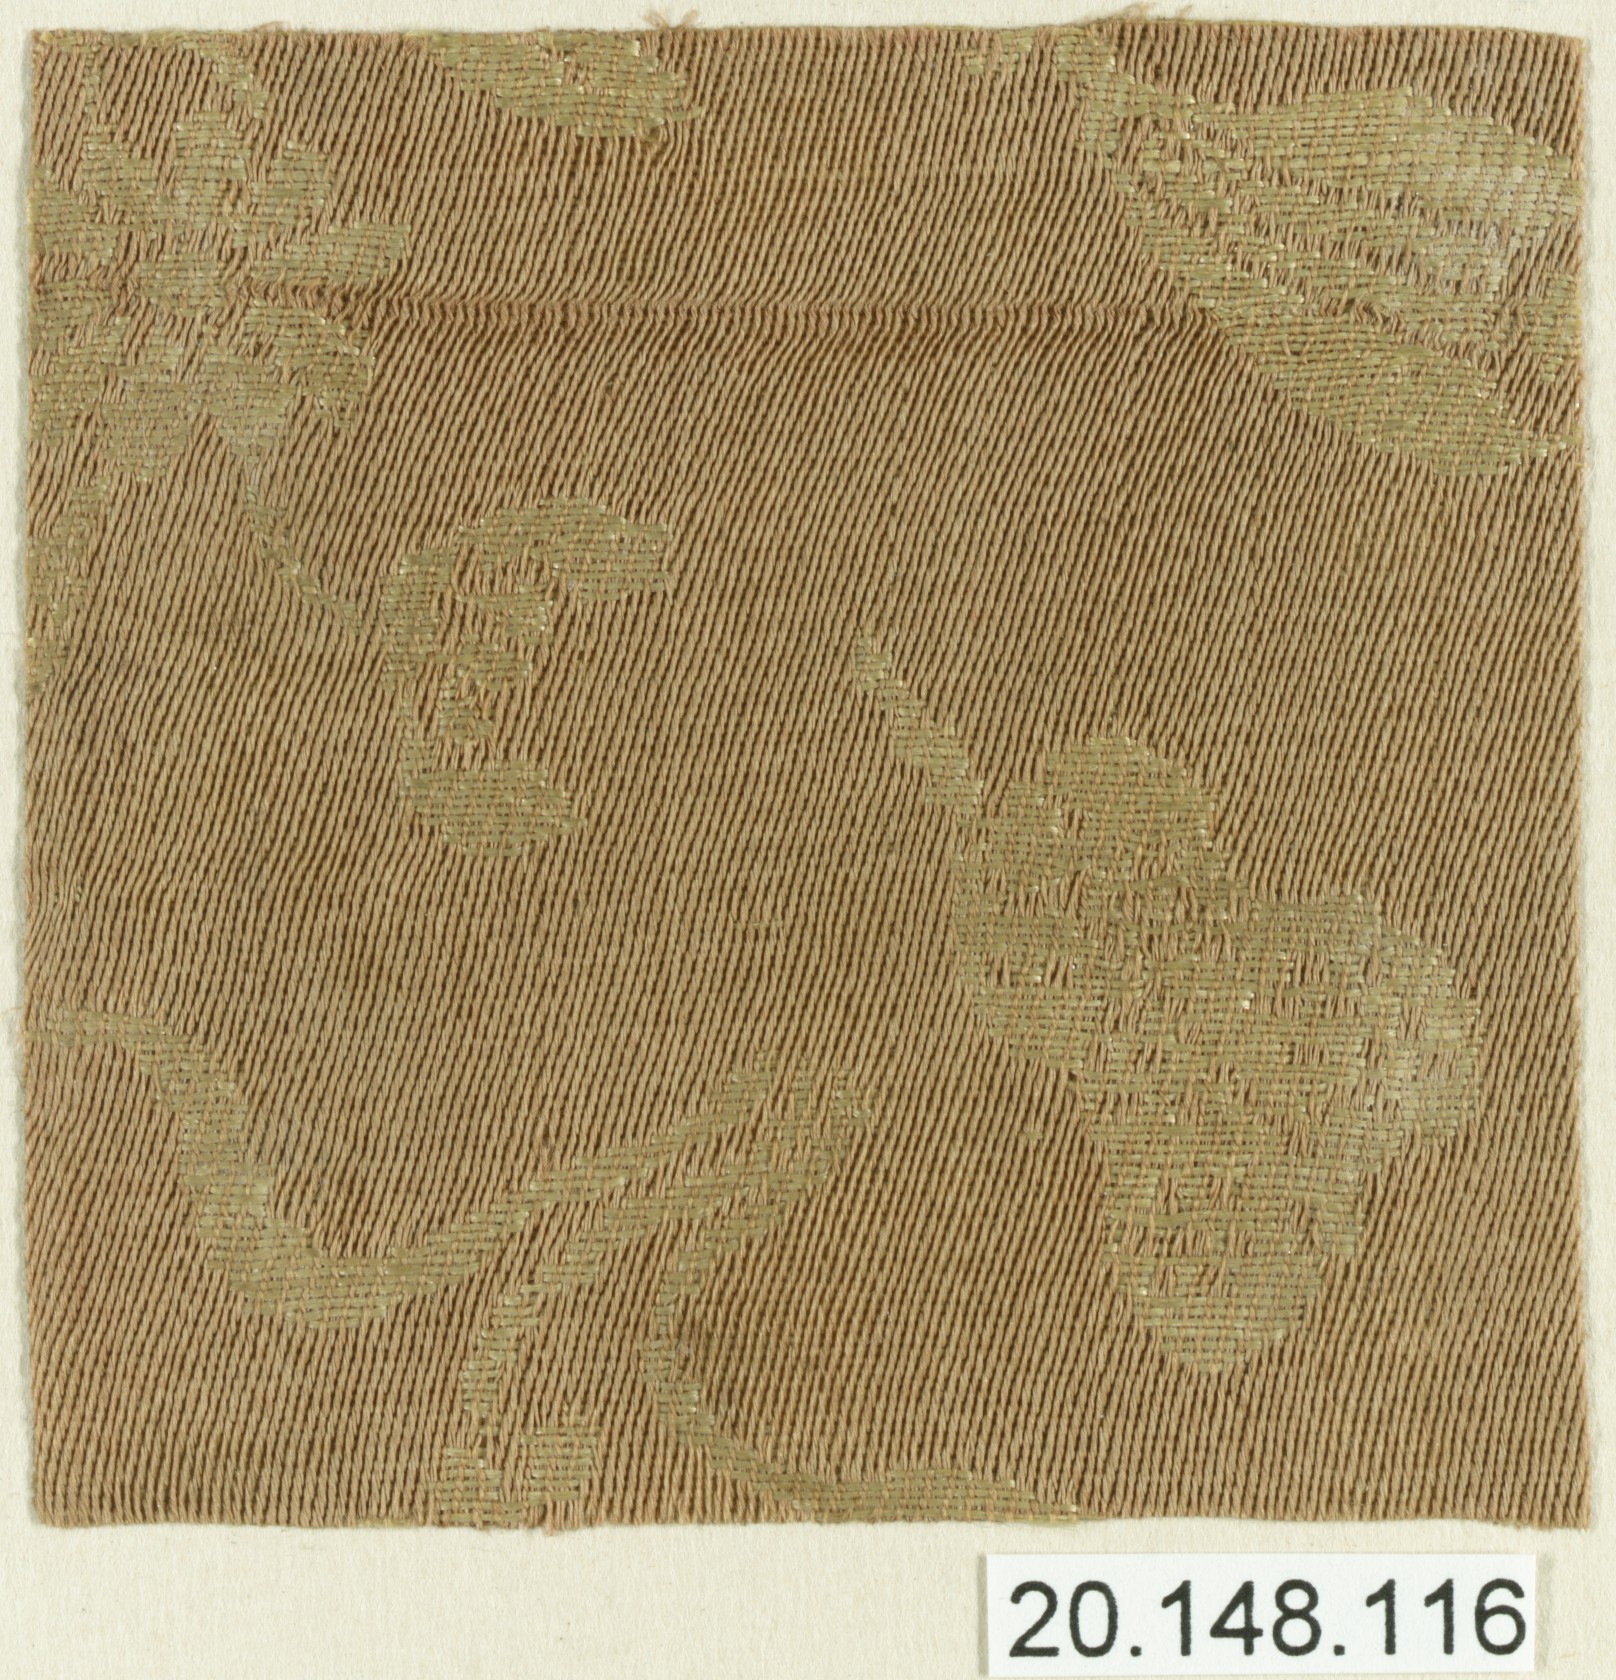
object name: piece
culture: japanese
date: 1601-1700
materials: silk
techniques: compound weave